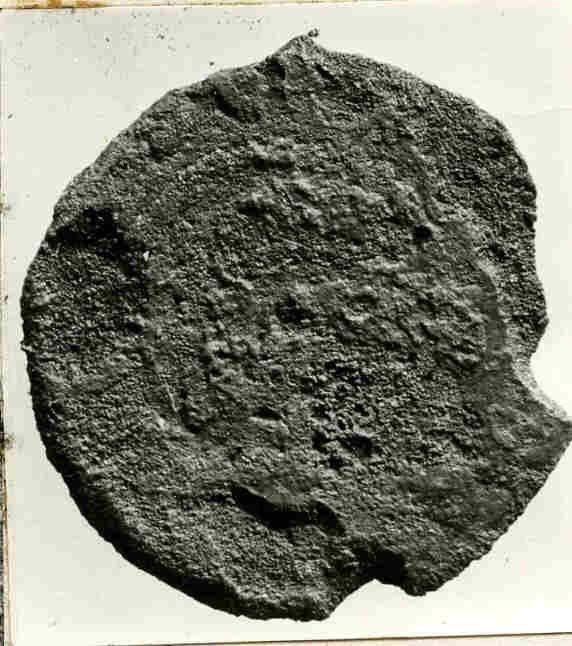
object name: coin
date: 701-900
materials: copper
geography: iran